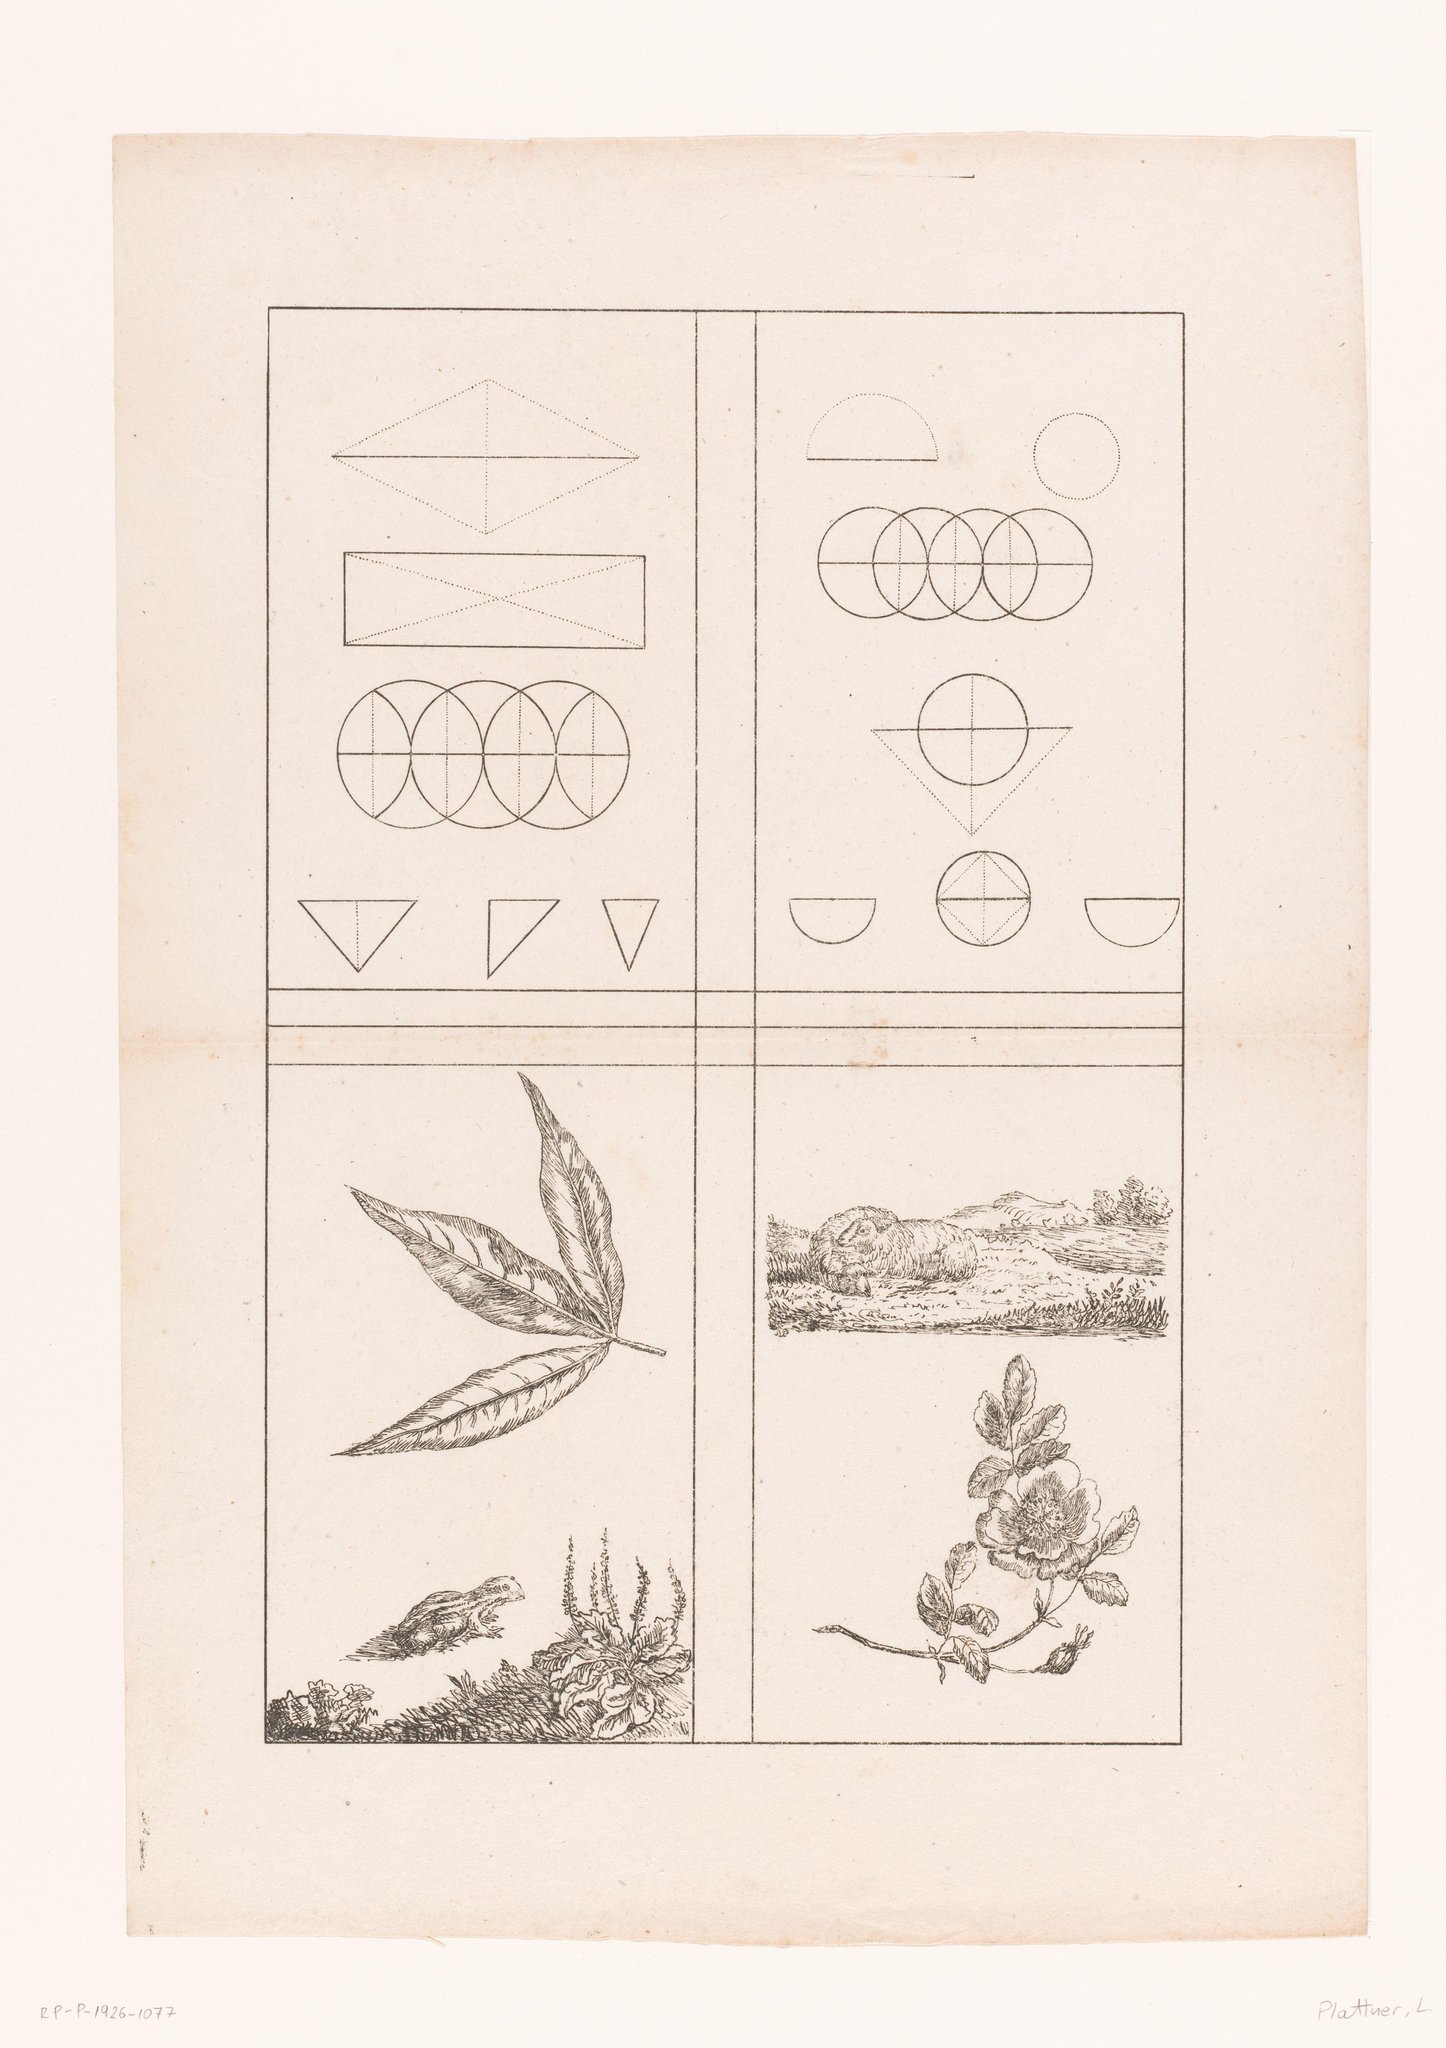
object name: print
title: Wiskundige vormen, planten en dieren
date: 1809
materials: paper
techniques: lithograph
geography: rotterdam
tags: plants (in general), animals, drawing (mathematics)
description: Een blad in vieren verdeeld. Aan de bovenzijde twee vakken met wiskundige vormen. Links onder een blad, een pad of hagedis en bloemen. Rechts onder twee liggende schapen in een landschap en een wilde roos.